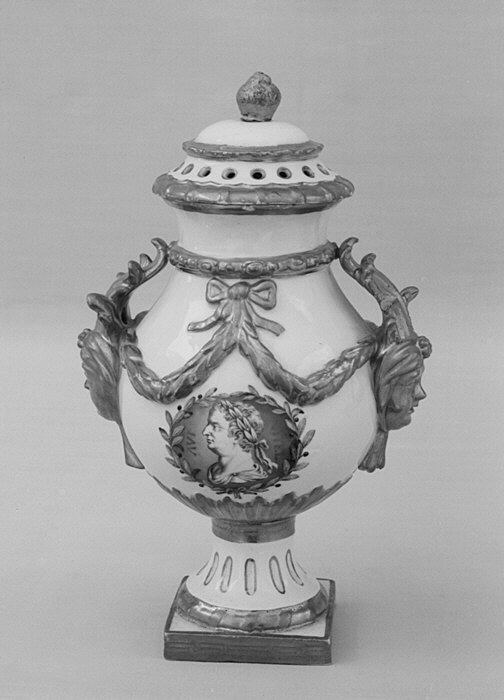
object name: vase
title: Vase (part of a garniture)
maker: fürstenberg porcelain manufactory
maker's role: manufactory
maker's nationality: german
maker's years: 1747-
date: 1780-1790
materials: hard paste porcelain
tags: men,profiles